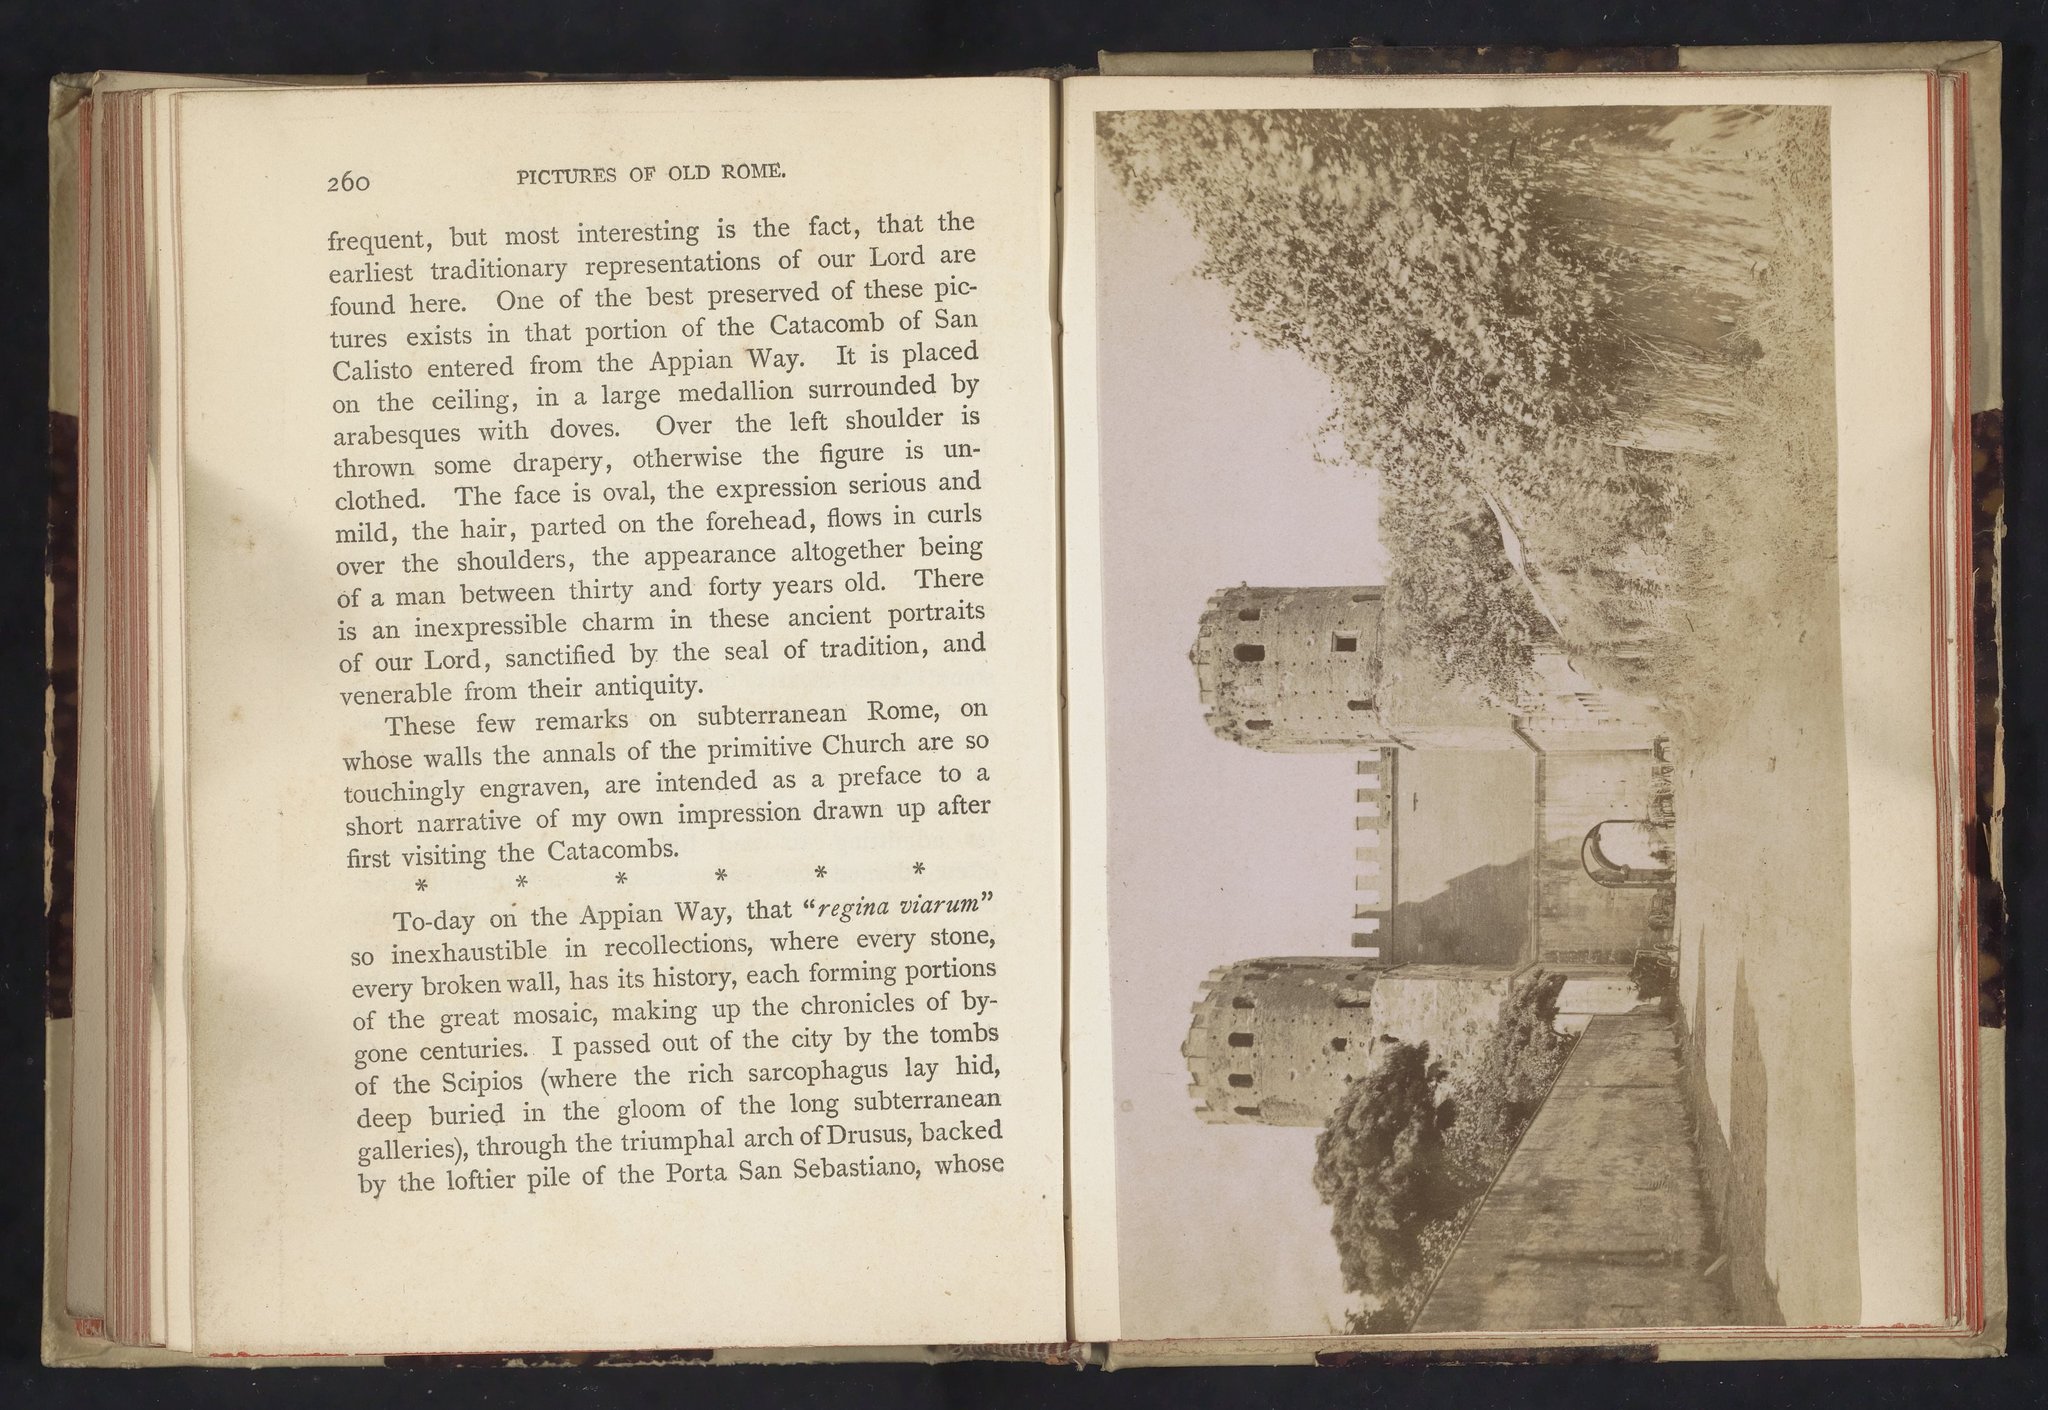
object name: page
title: Gezicht op de Porta San Sebastiano te Rome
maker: Anonymous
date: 1872-1882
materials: photographic support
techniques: albumen print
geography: rome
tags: gate, entrance